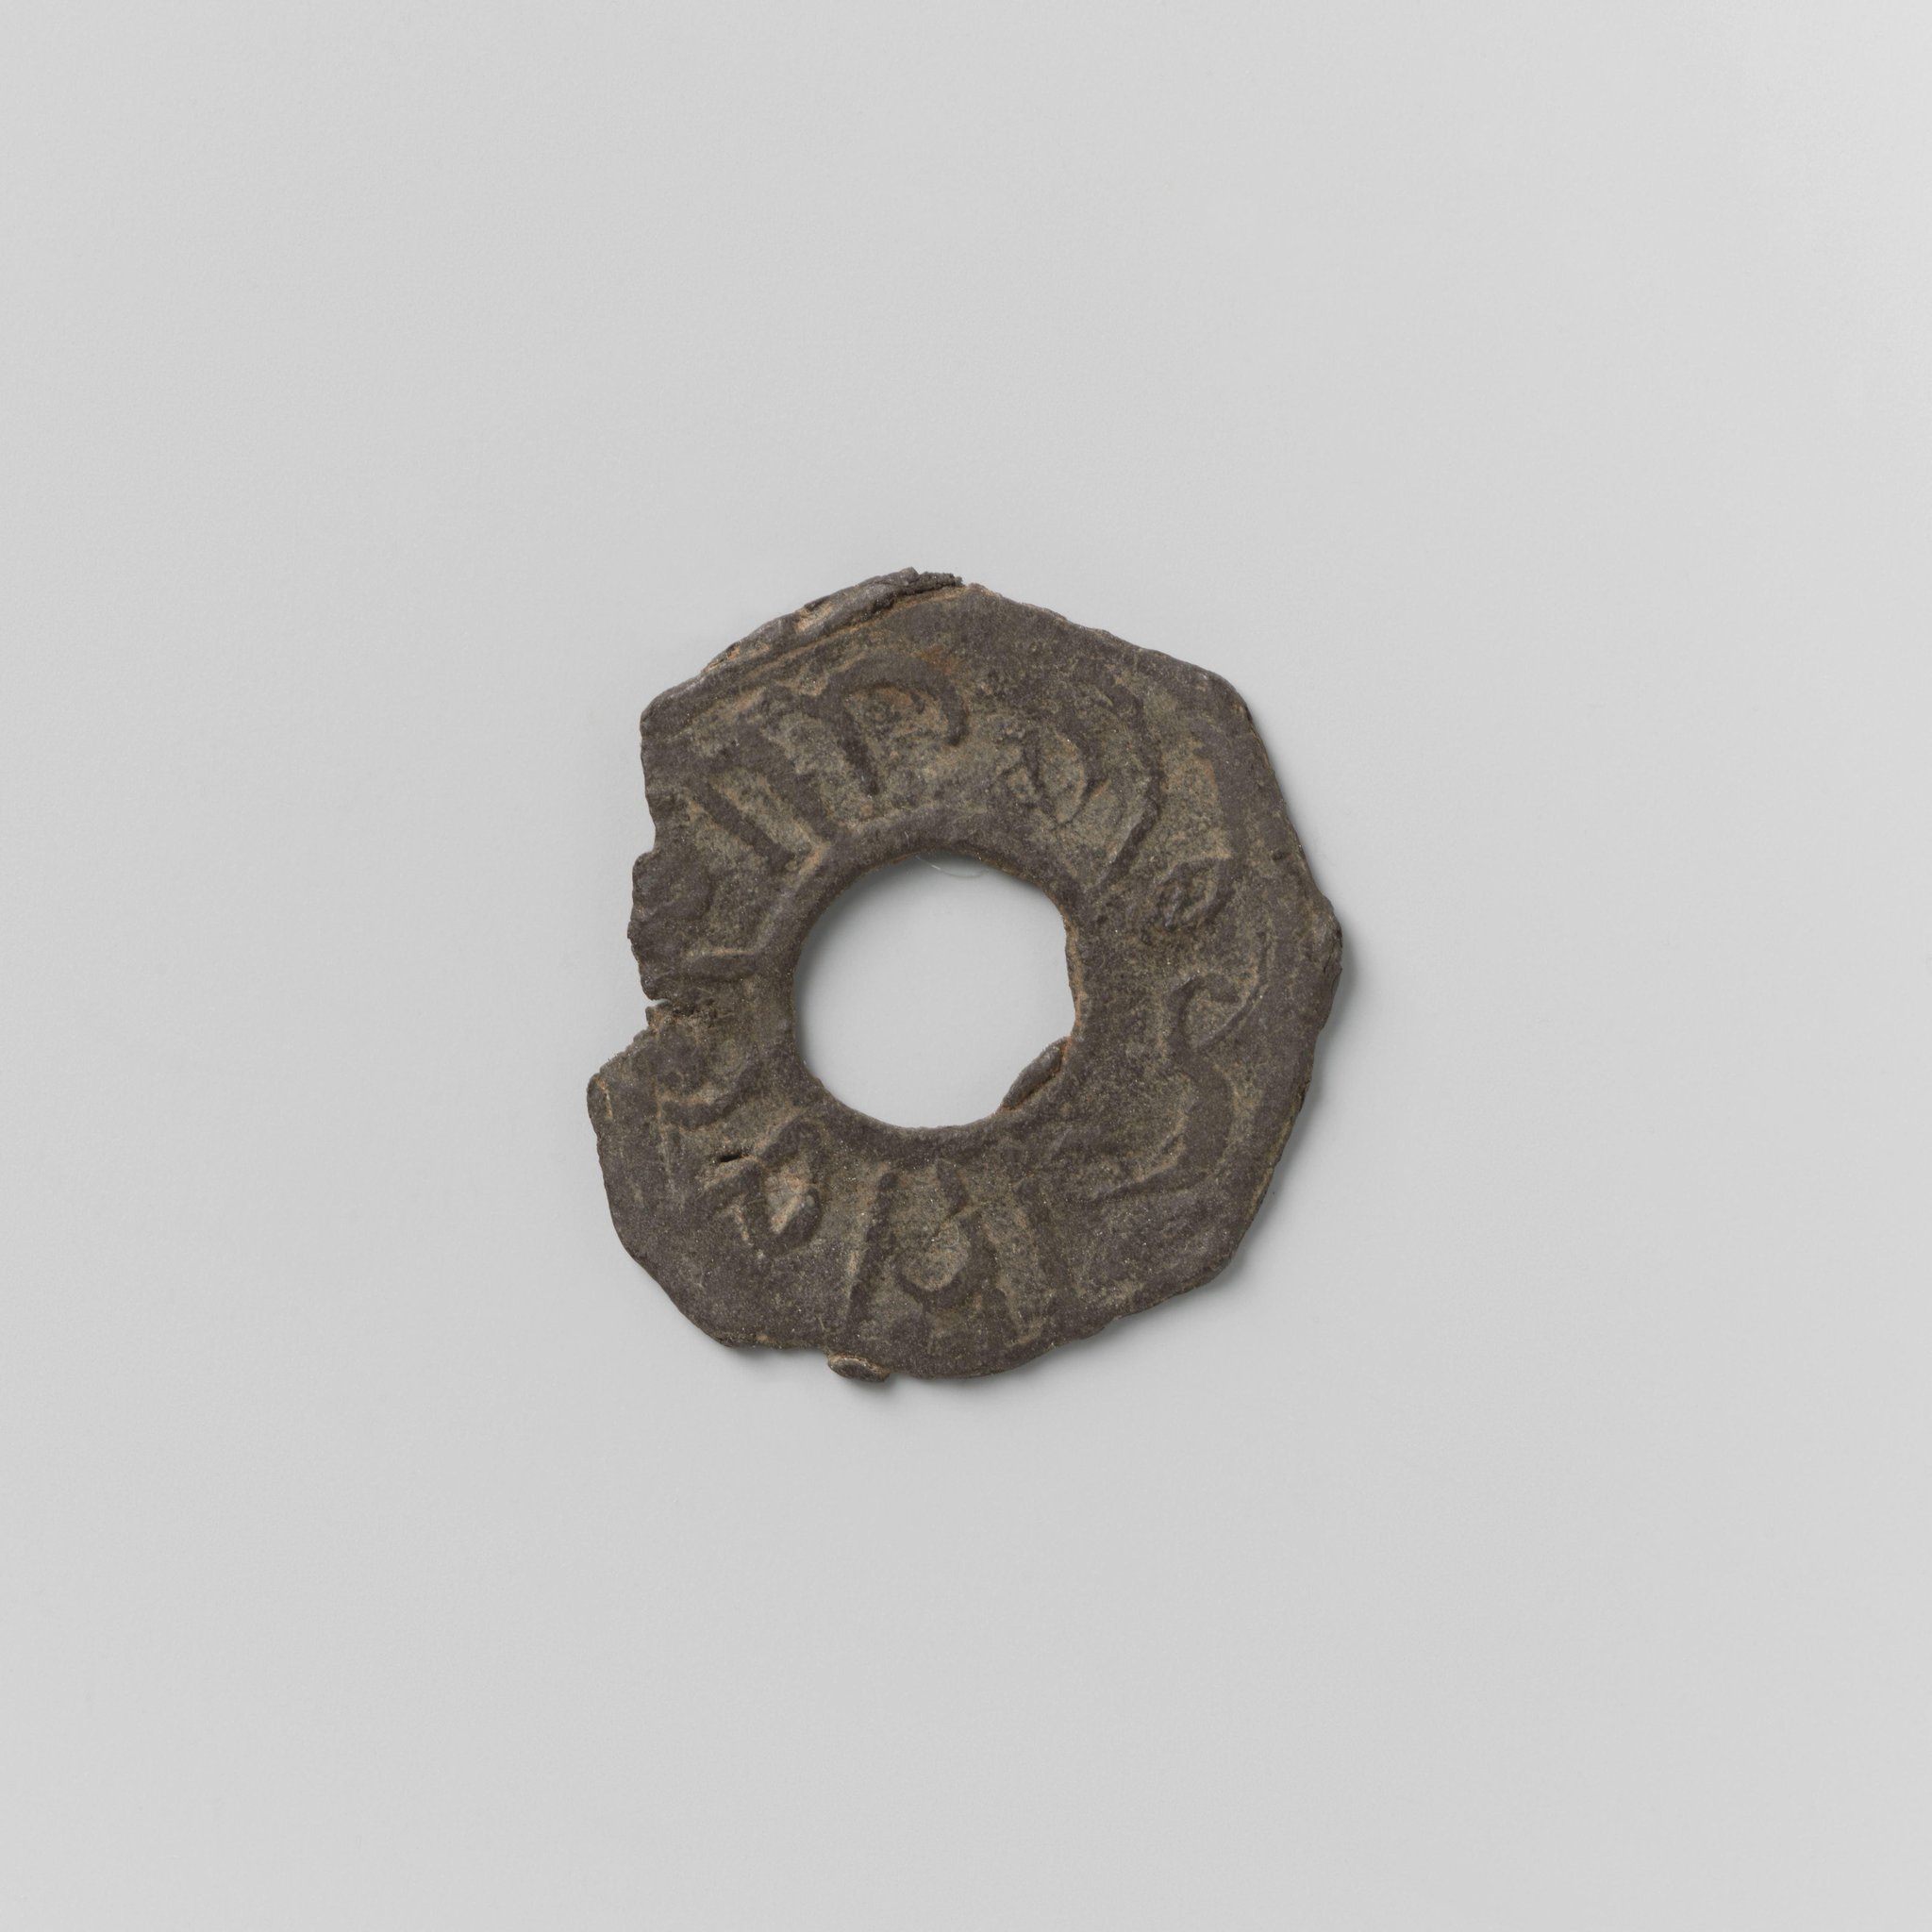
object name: coin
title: Palembang, Sumatra, sultan Mamoed Bader ed-din II, pitji, A.H. 1219 (1804)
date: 1804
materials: tin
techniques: casting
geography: palembang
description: Tinnen achthoekige munt. Voorzijde: omschrift in Arabische lettertekens, waartussen jaartal in Islamitische jaartelling. Keerzijde, glad. In het midden rond gat.